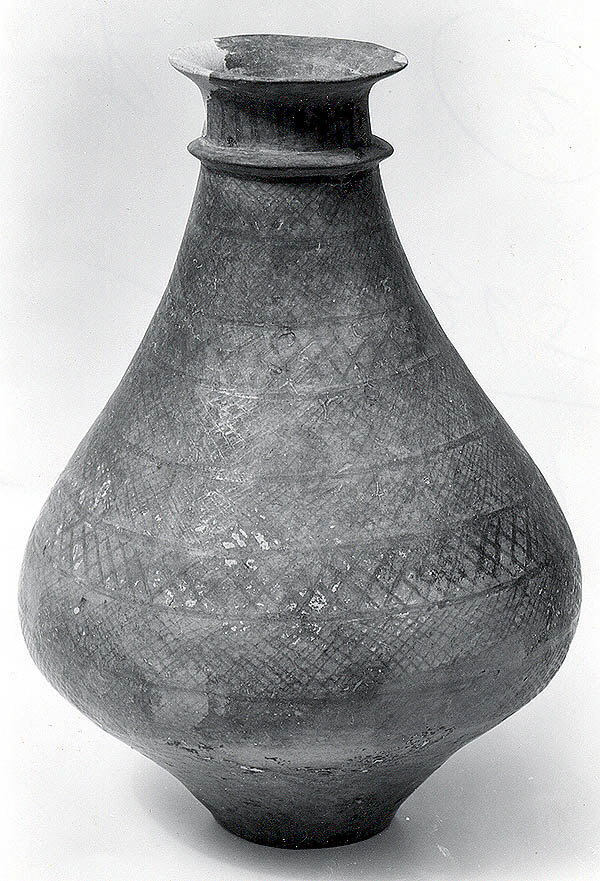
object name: jar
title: Piriform jar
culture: iranian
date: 3000-2250 BCE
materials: ceramic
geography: iran